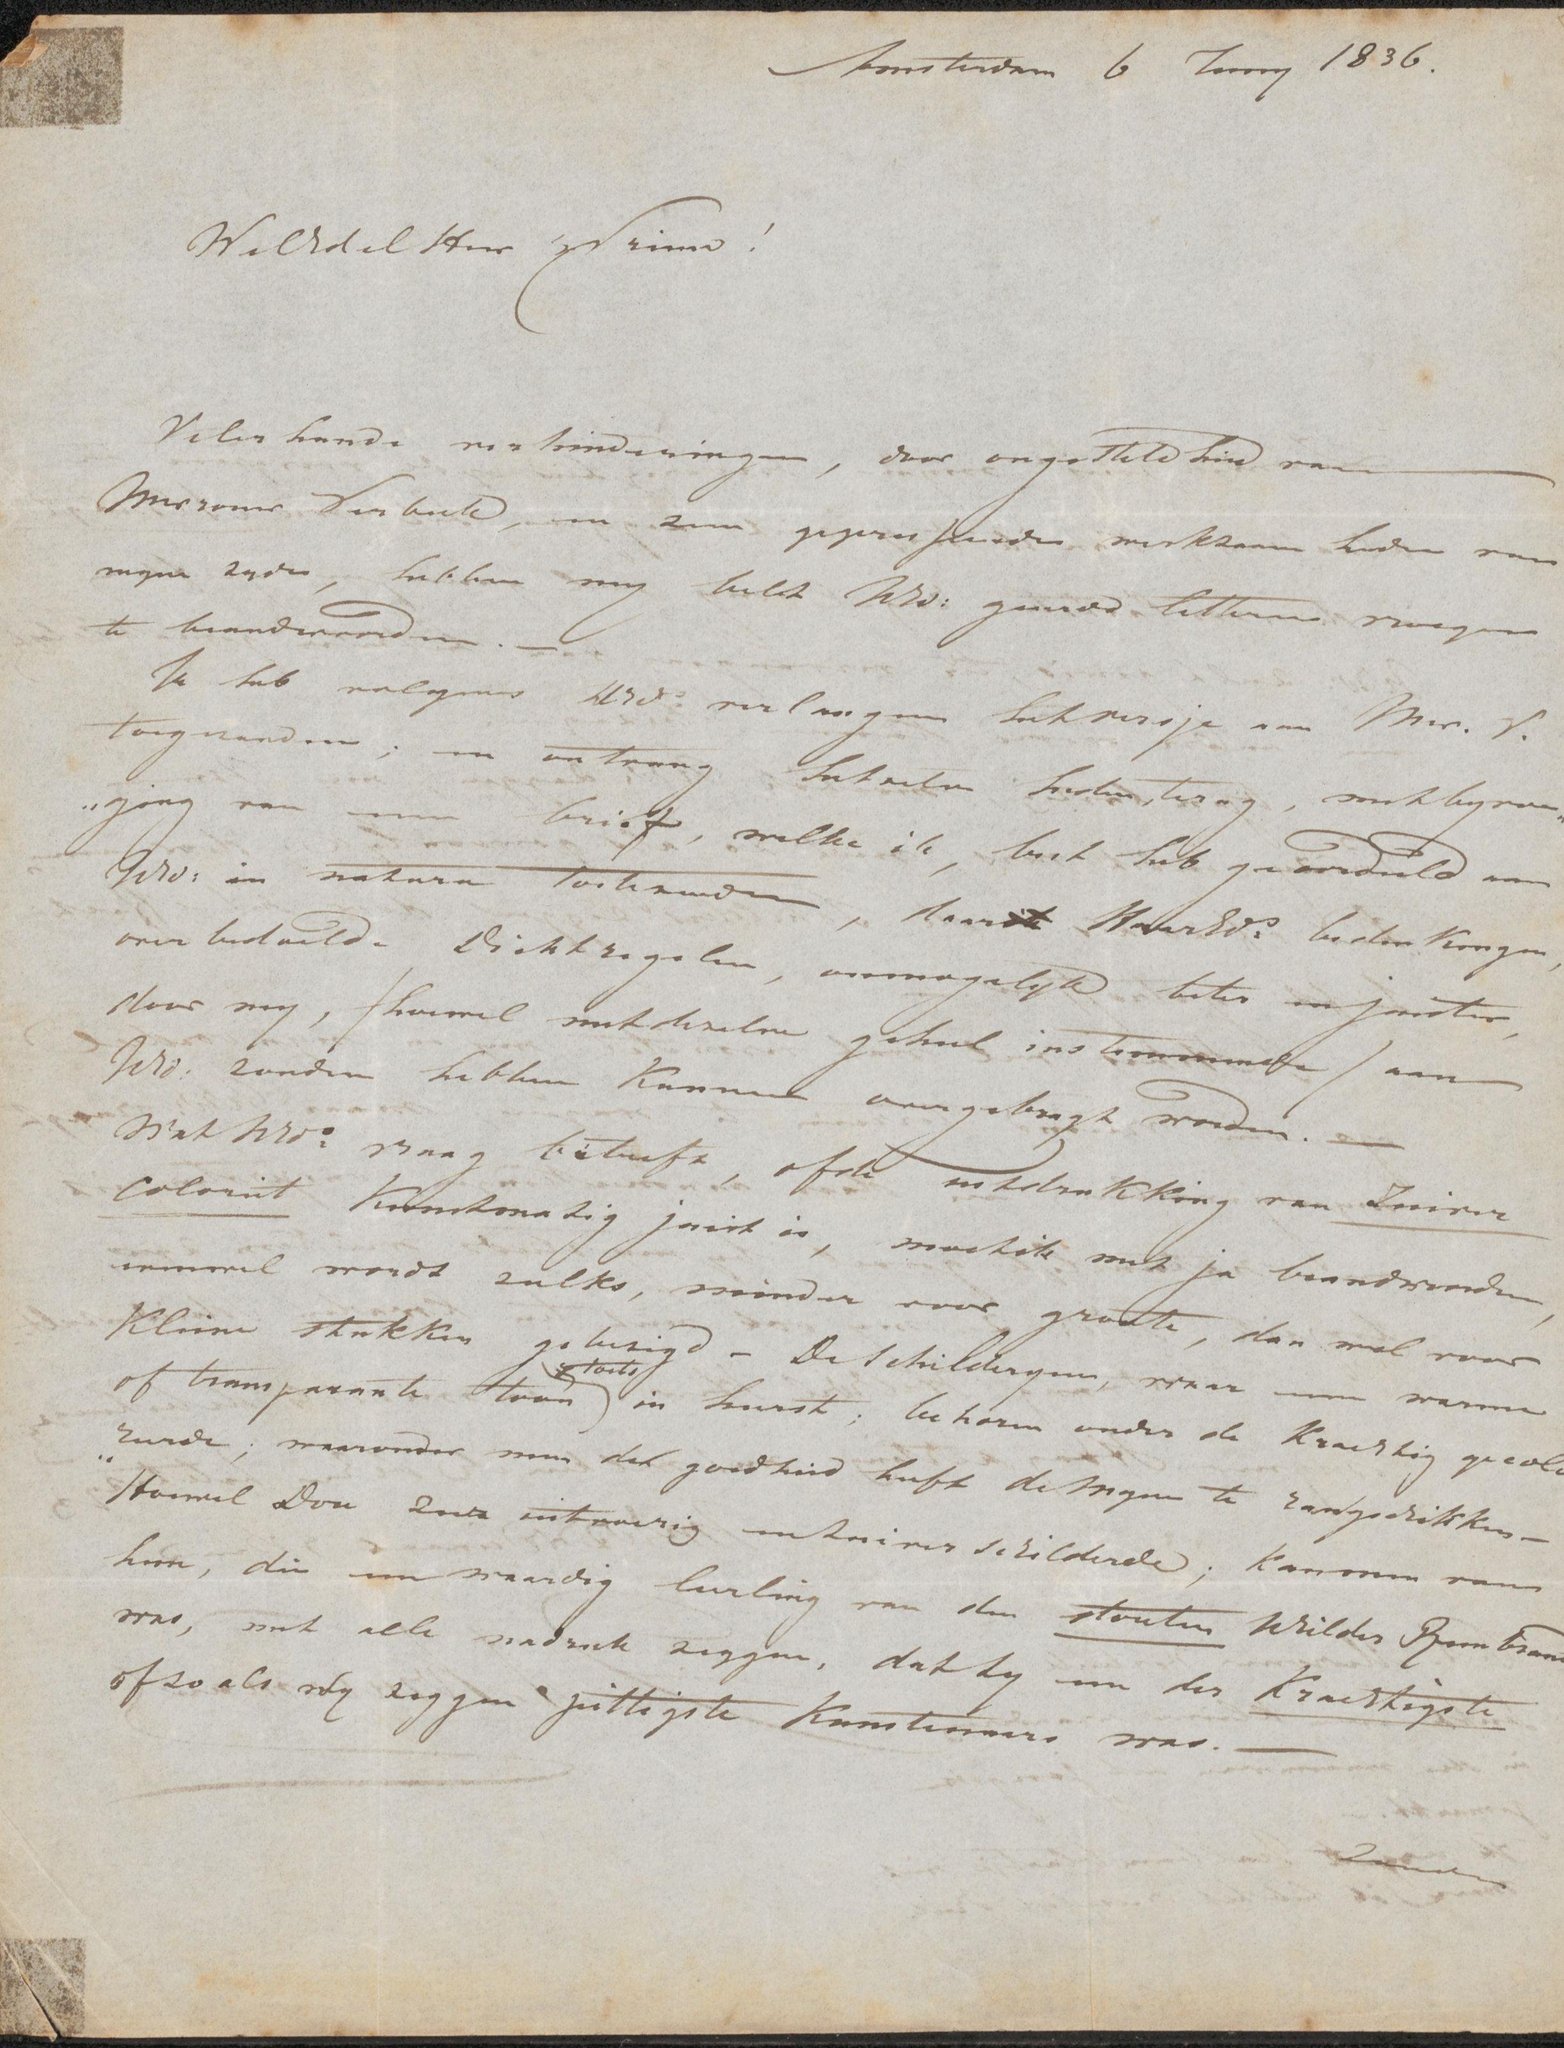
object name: letter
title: Brief aan anoniem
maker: jan adam kruseman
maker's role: draughtsman, painter, print maker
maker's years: 1804-1862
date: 1836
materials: ink, paper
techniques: pen, writing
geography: amsterdam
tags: painting (including book-illumination, miniature-painting), diseases